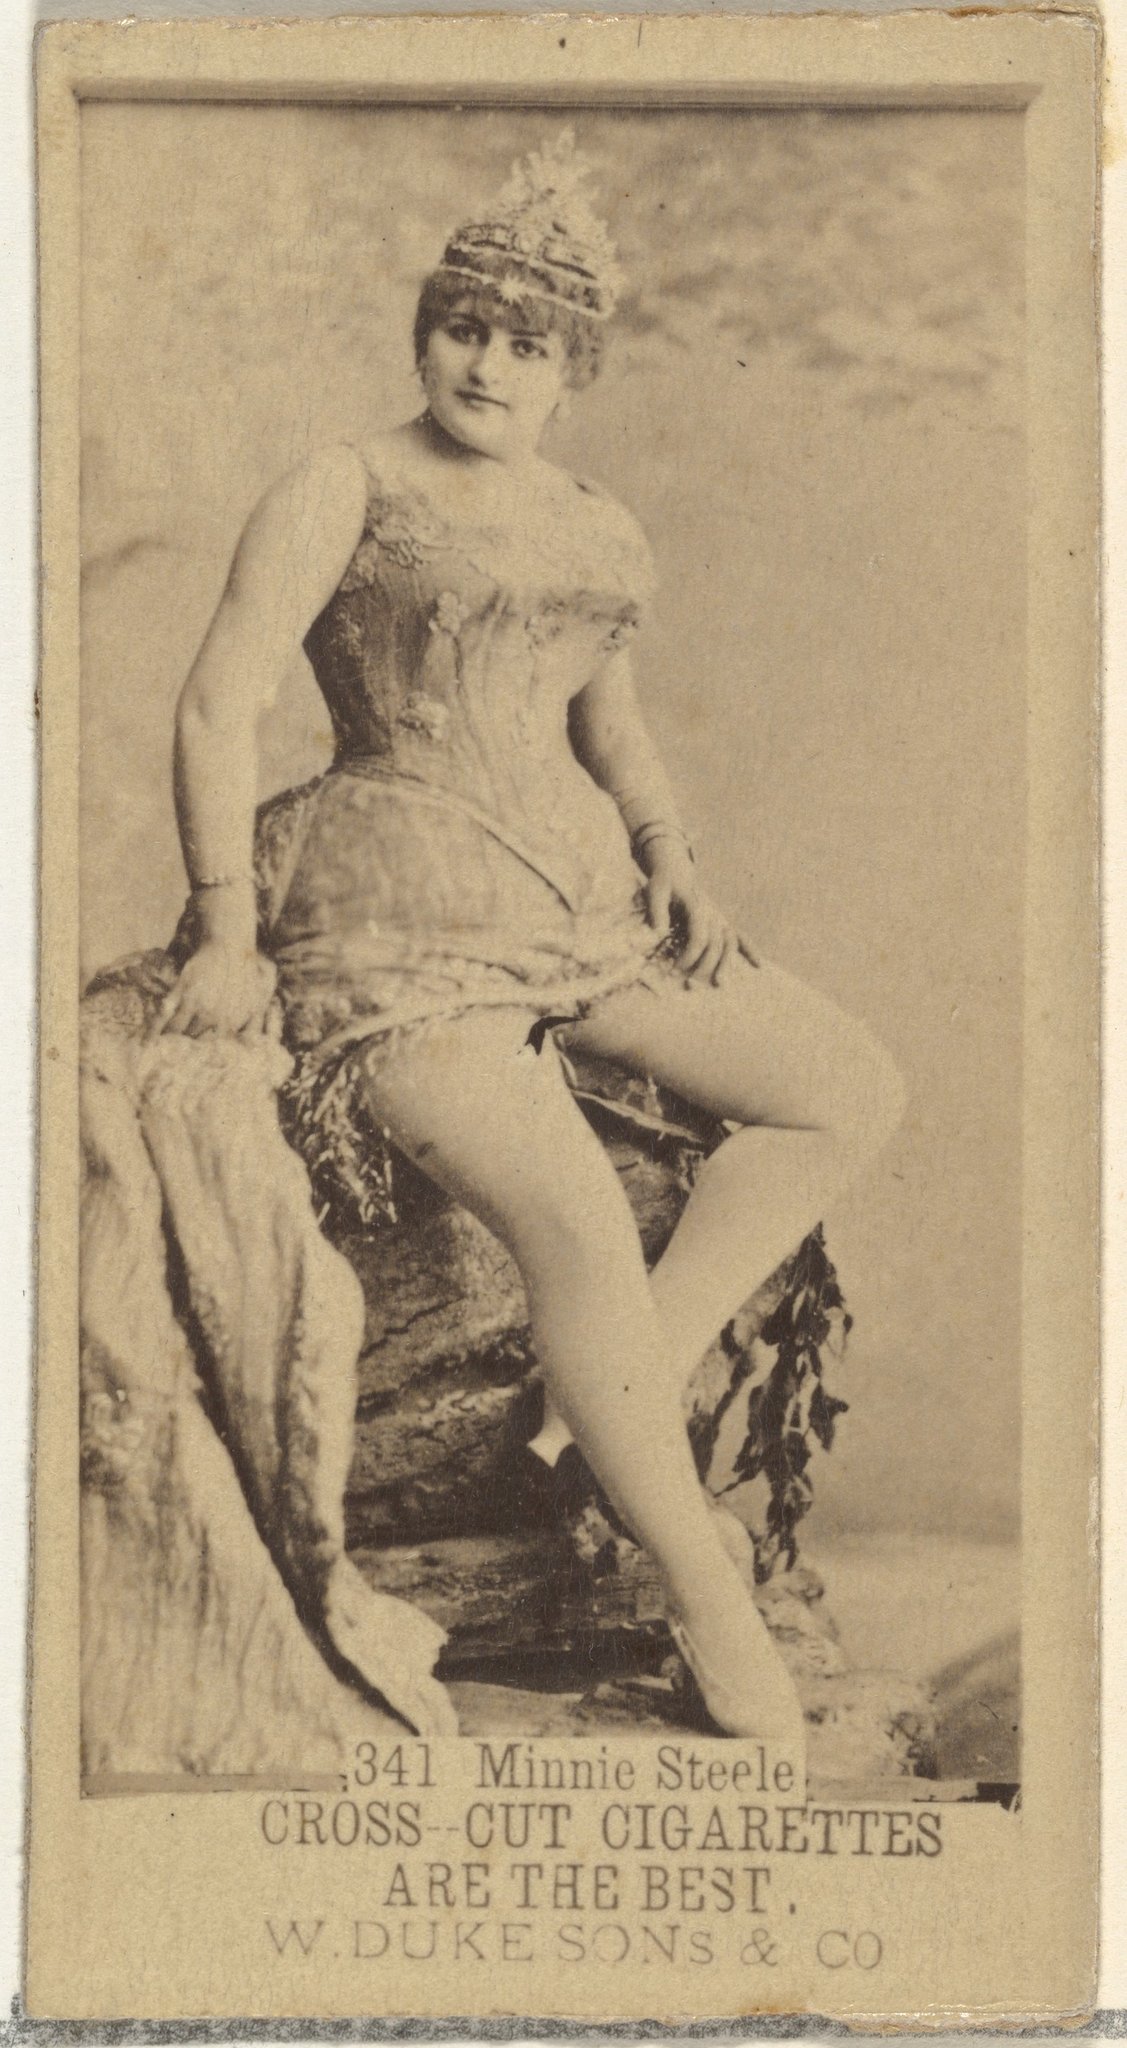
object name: photograph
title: Card Number 341, Minnie Steele, from the Actors and Actresses series (N145-3) issued by Duke Sons & Co. to promote Cross Cut Cigarettes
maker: w. duke, sons & co.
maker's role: publisher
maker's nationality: american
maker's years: 1870-1920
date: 1880-1889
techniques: albumen silver print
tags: portraits,women,actresses